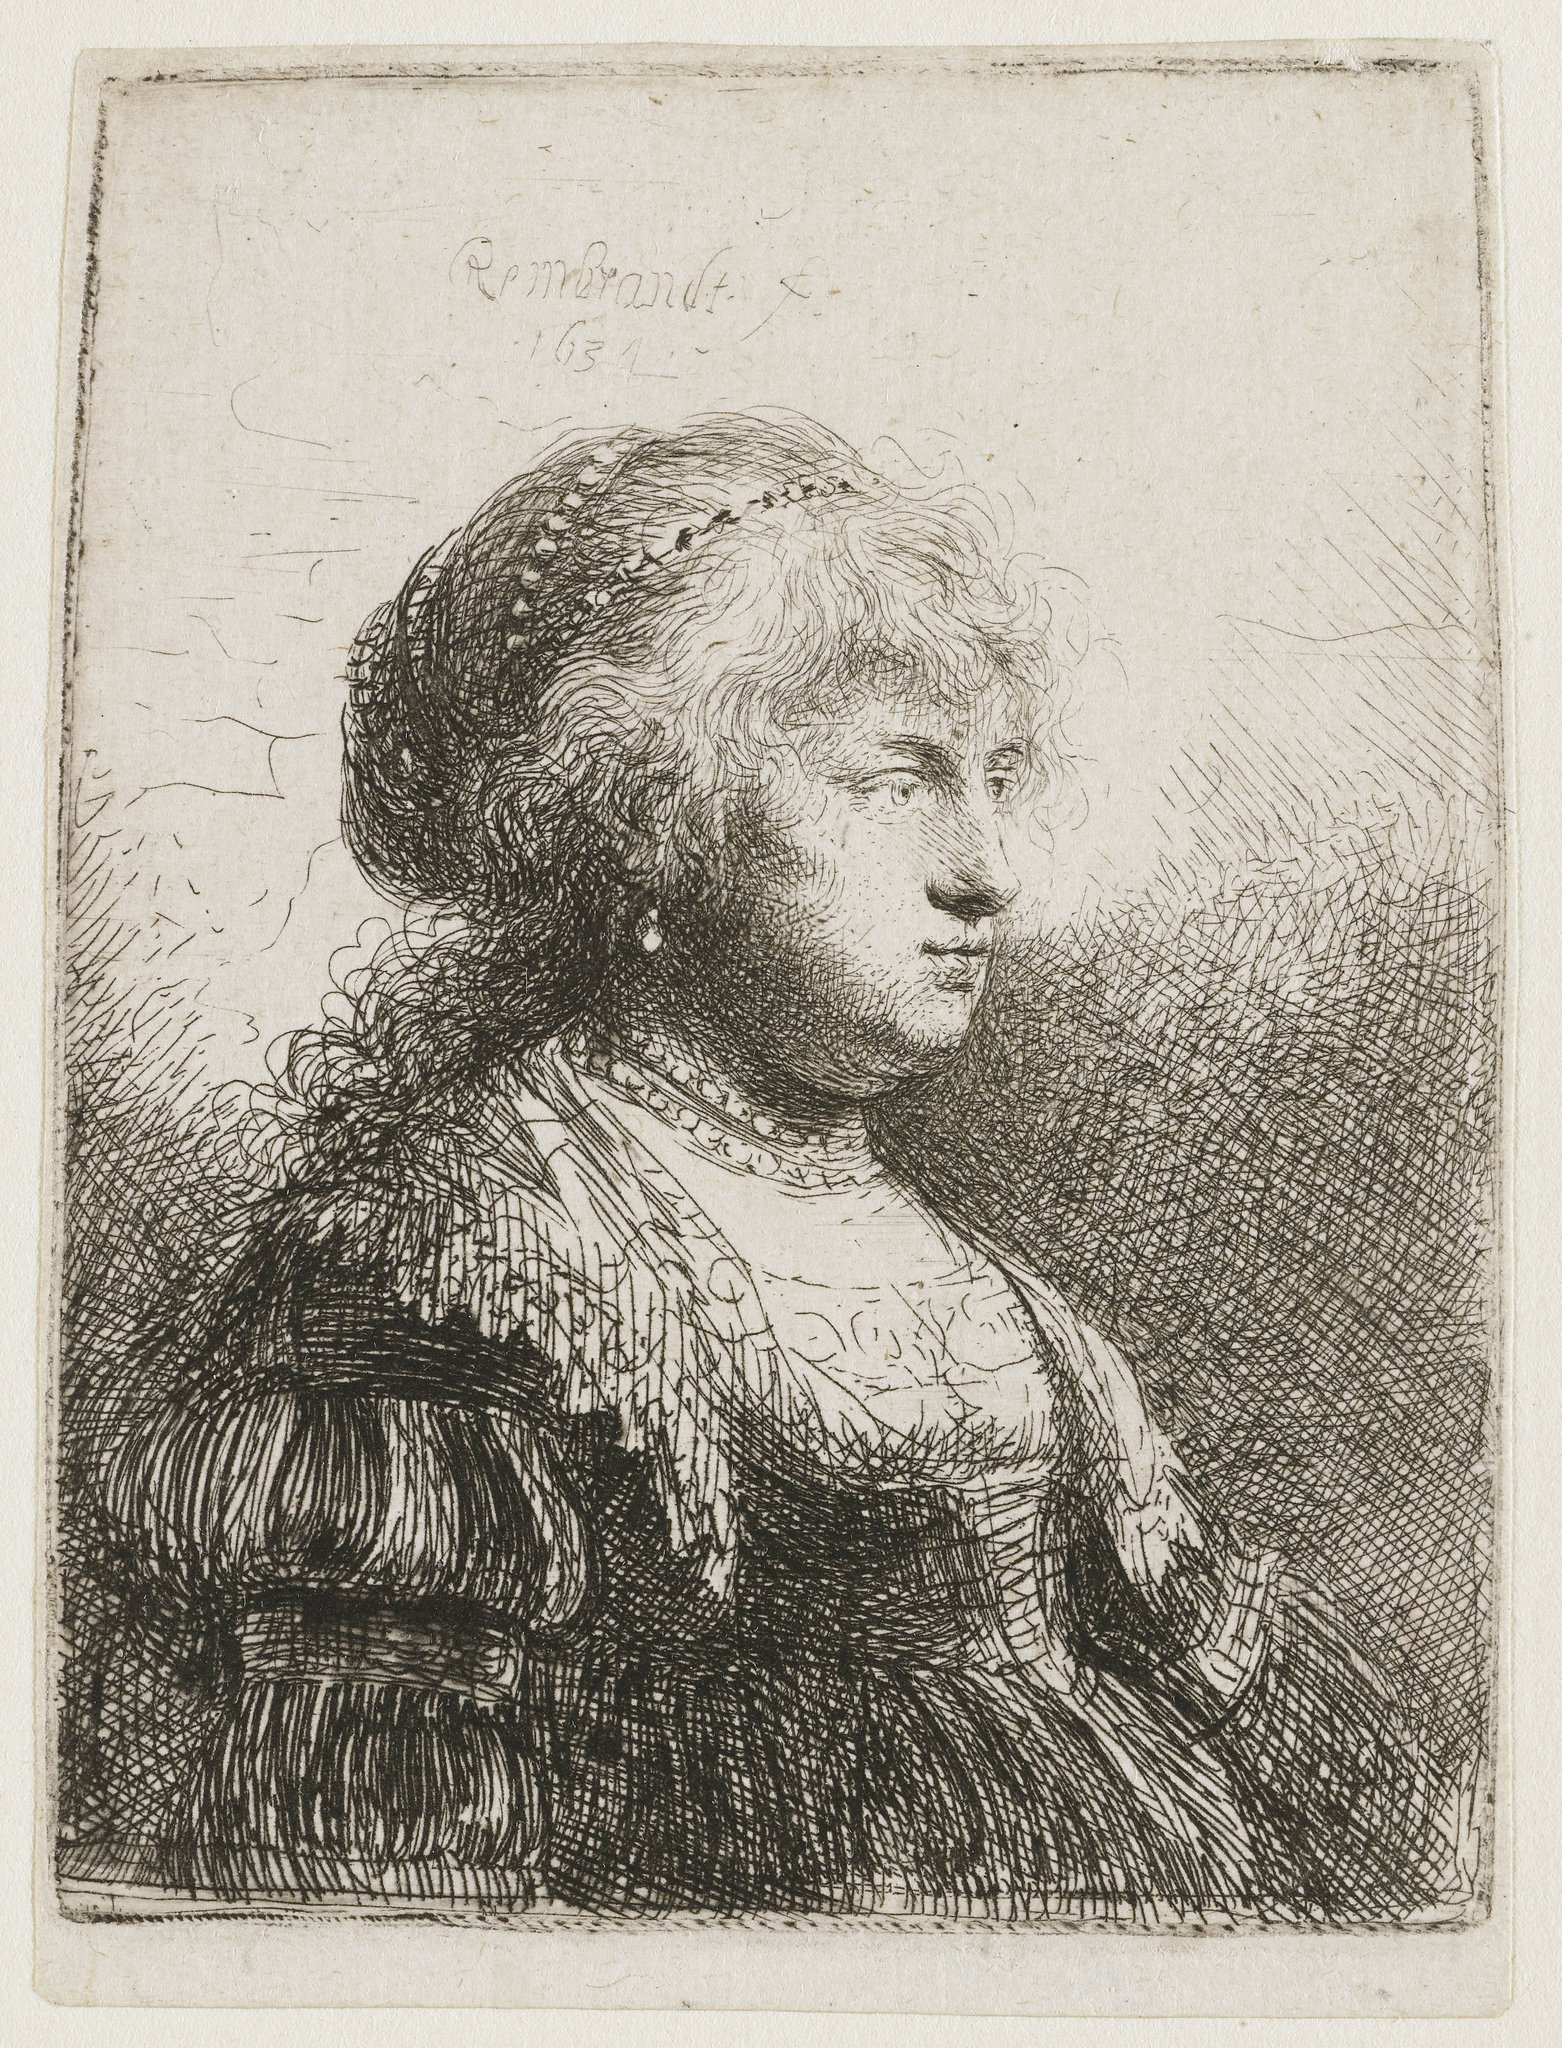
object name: print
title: Saskia with Pearls in her Hair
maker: rembrandt van rijn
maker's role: draughtsman, painter, print maker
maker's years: 1606-1669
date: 1634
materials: paper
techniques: etching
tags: amsterdam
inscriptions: collector's mark: Lugt 240, signature and date: ‘Rembrandt f 1634’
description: This small etching of a young woman from 1634 was only recently identified as a portrait of Rembrandt’s wife, Saskia. Pearls are woven in her hair and hang from her neck and ears. The gown and the lace kerchief around her shoulders are fashionable and contemporary. Rembrandt and Saskia wed in 1634; hence, this may well be a portrait of her in bridal attire.